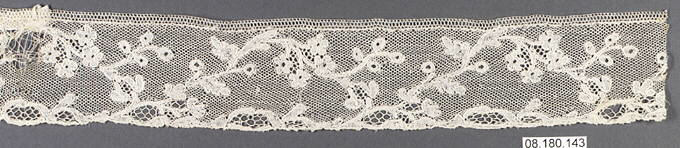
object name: piece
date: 1701-1800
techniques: lace